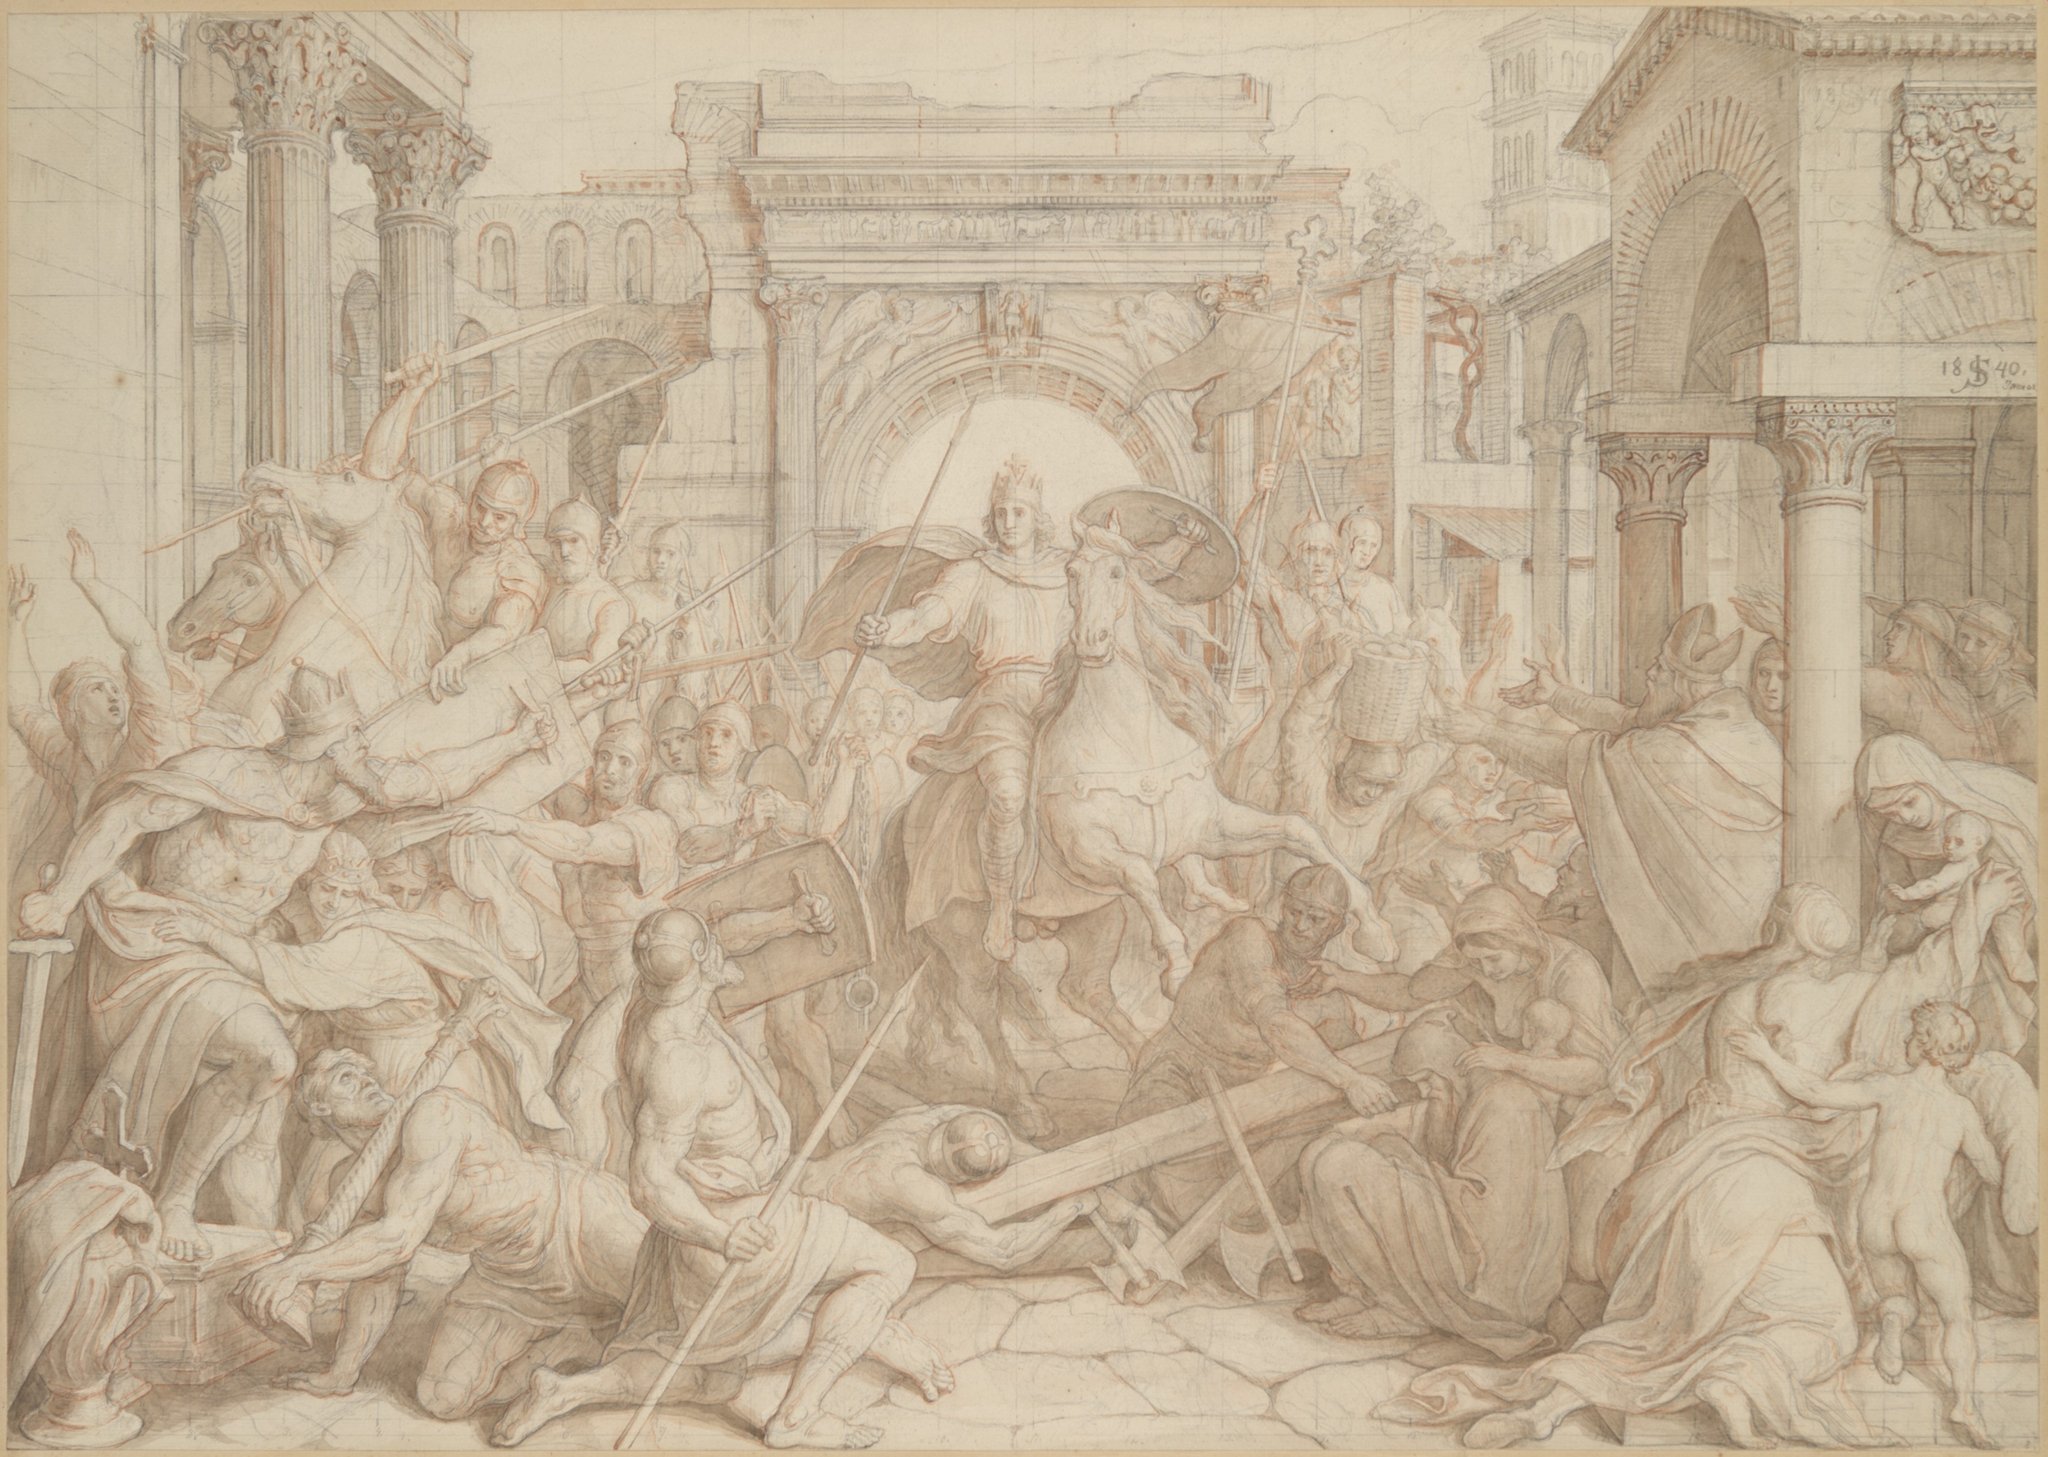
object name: drawing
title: The Entrance of Charlemagne into Pavia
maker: julius schnorr von carolsfeld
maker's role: artist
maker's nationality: german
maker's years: 1794-1872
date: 1840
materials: chalk, graphite, watercolor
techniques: drawing, transfer, wash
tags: soldiers,shields,spears,children,men,women,horses